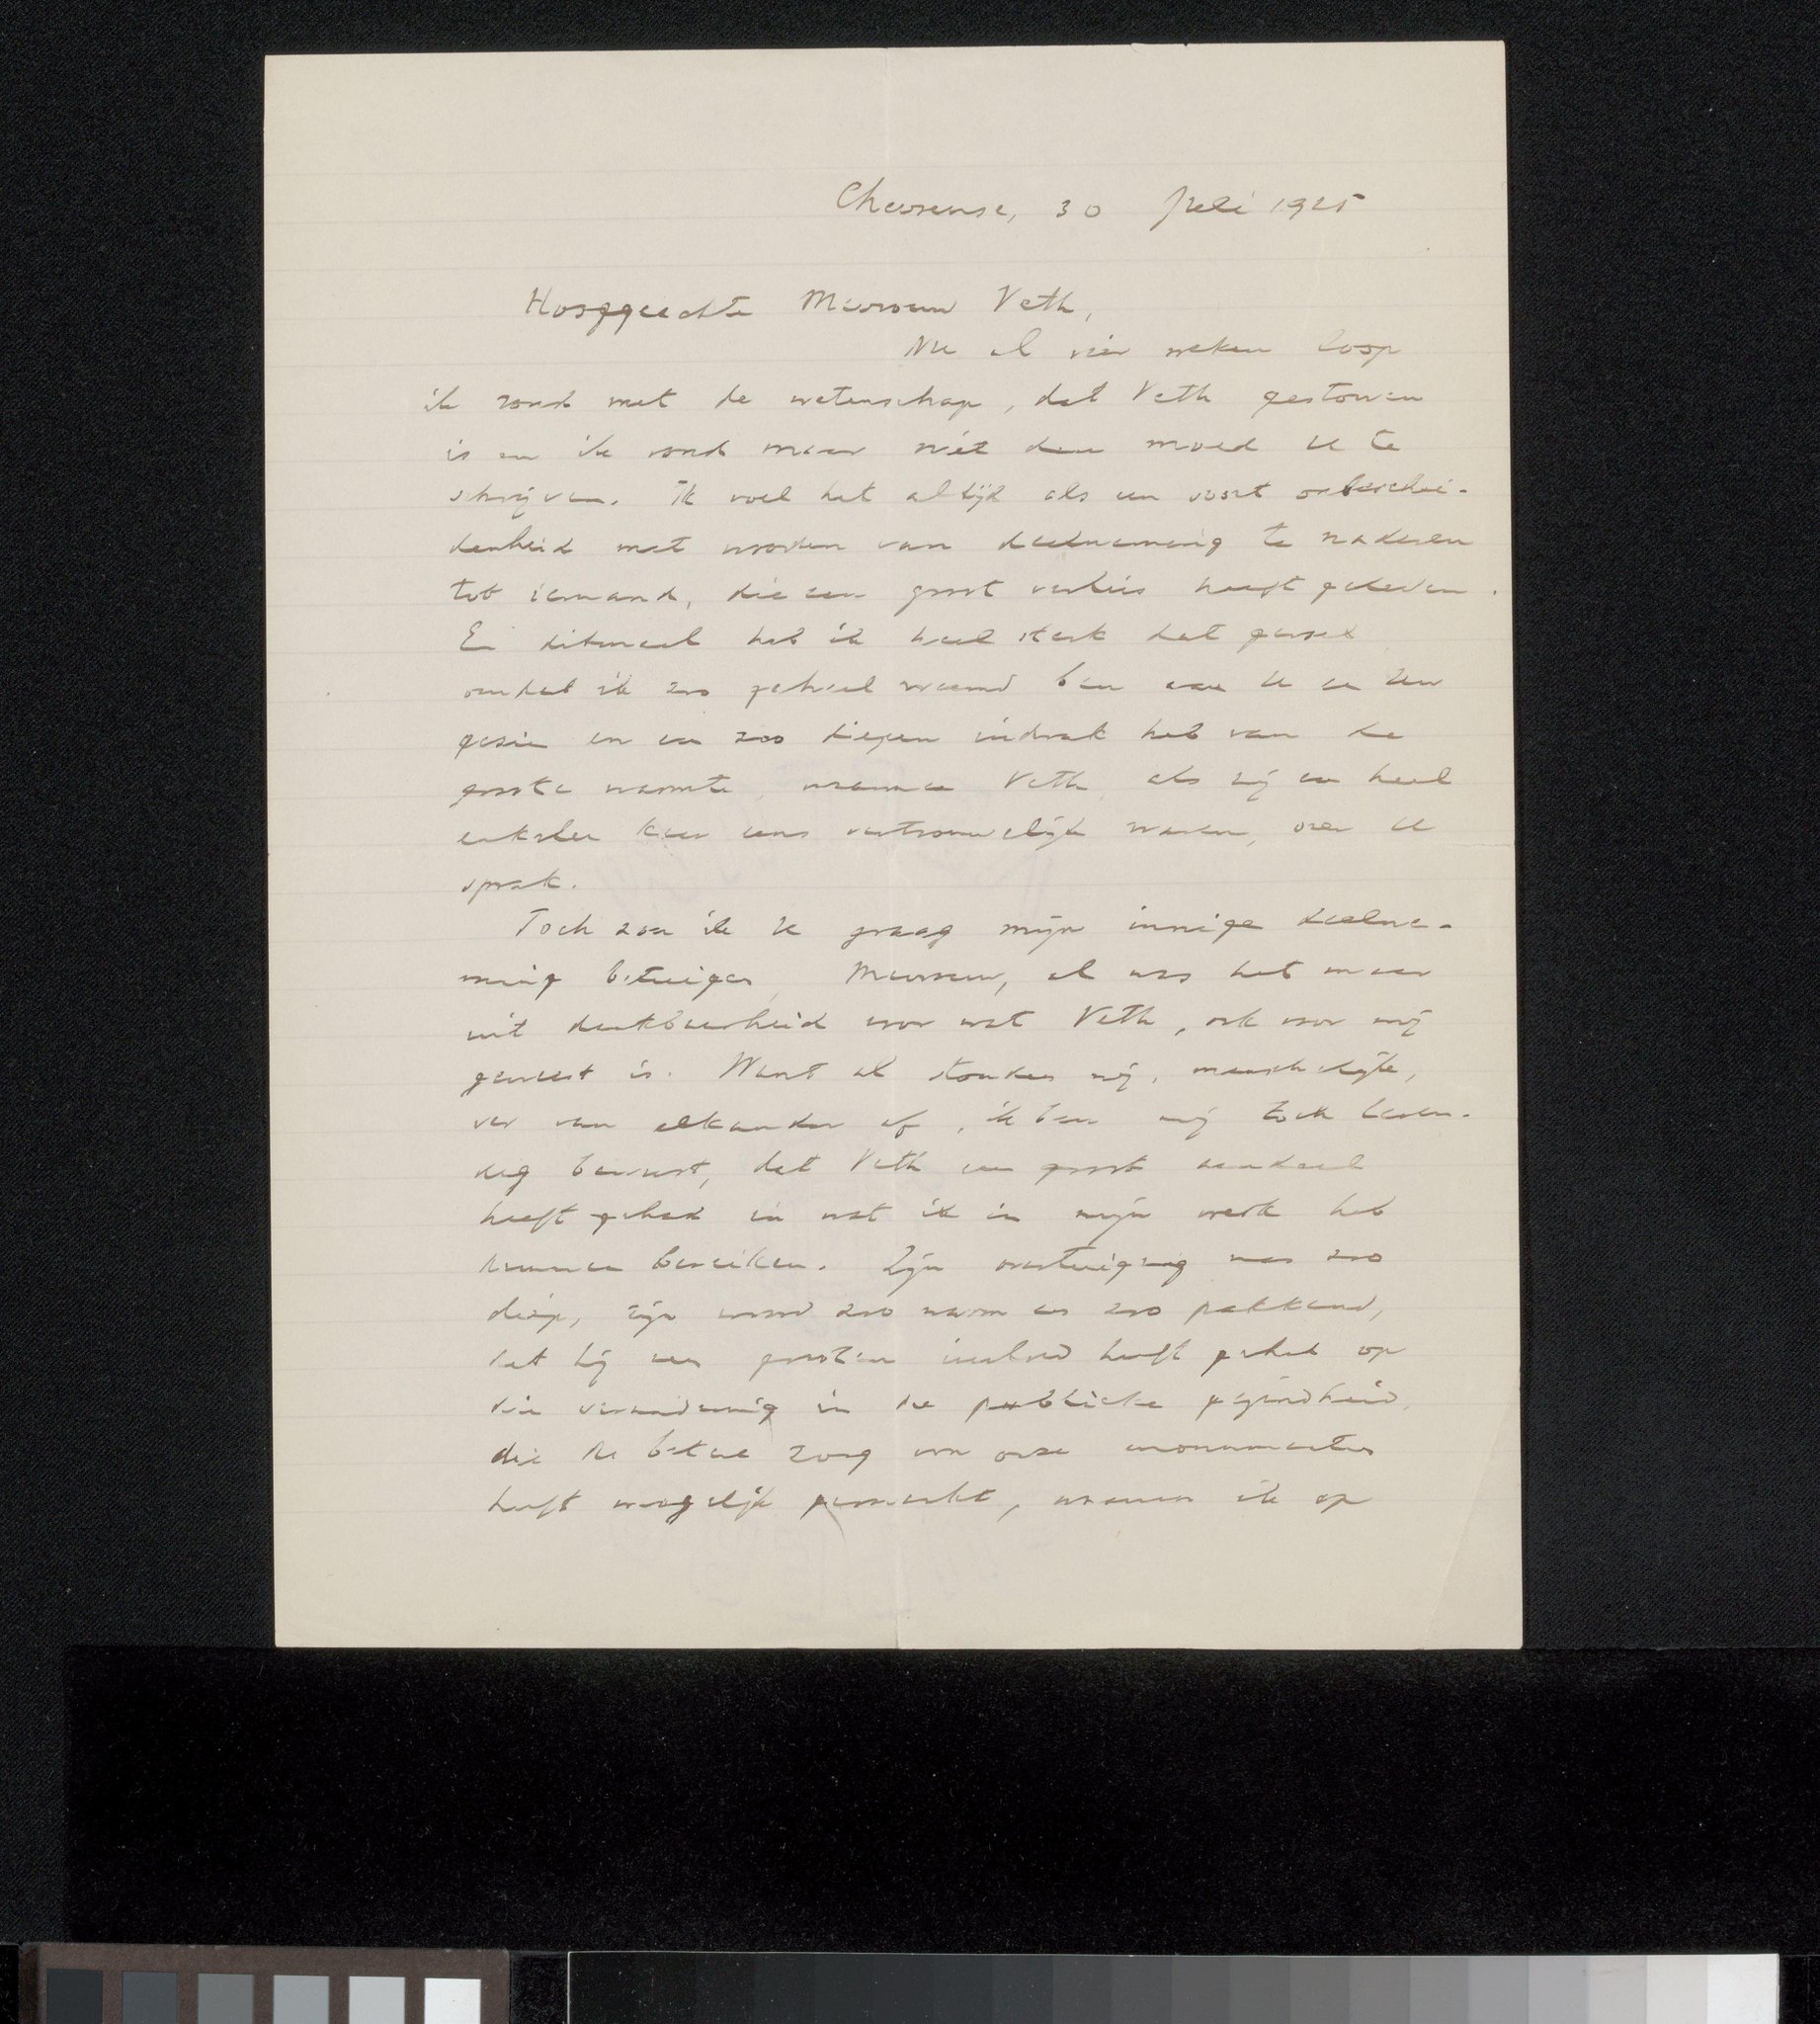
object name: letter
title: Brief aan Anna Dorothea Dirks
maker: jan kalff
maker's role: schrijver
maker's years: 1865-1944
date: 1925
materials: ink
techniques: typewriting, writing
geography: chevreuse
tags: dordrecht, painter, designer, jan veth, den helder, print maker, draughtsman, karel petrus cornelis de bazel, artist, anna dorothea dirks, passions, emotions, affections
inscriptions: watermark, collector's mark: ‘RPK’